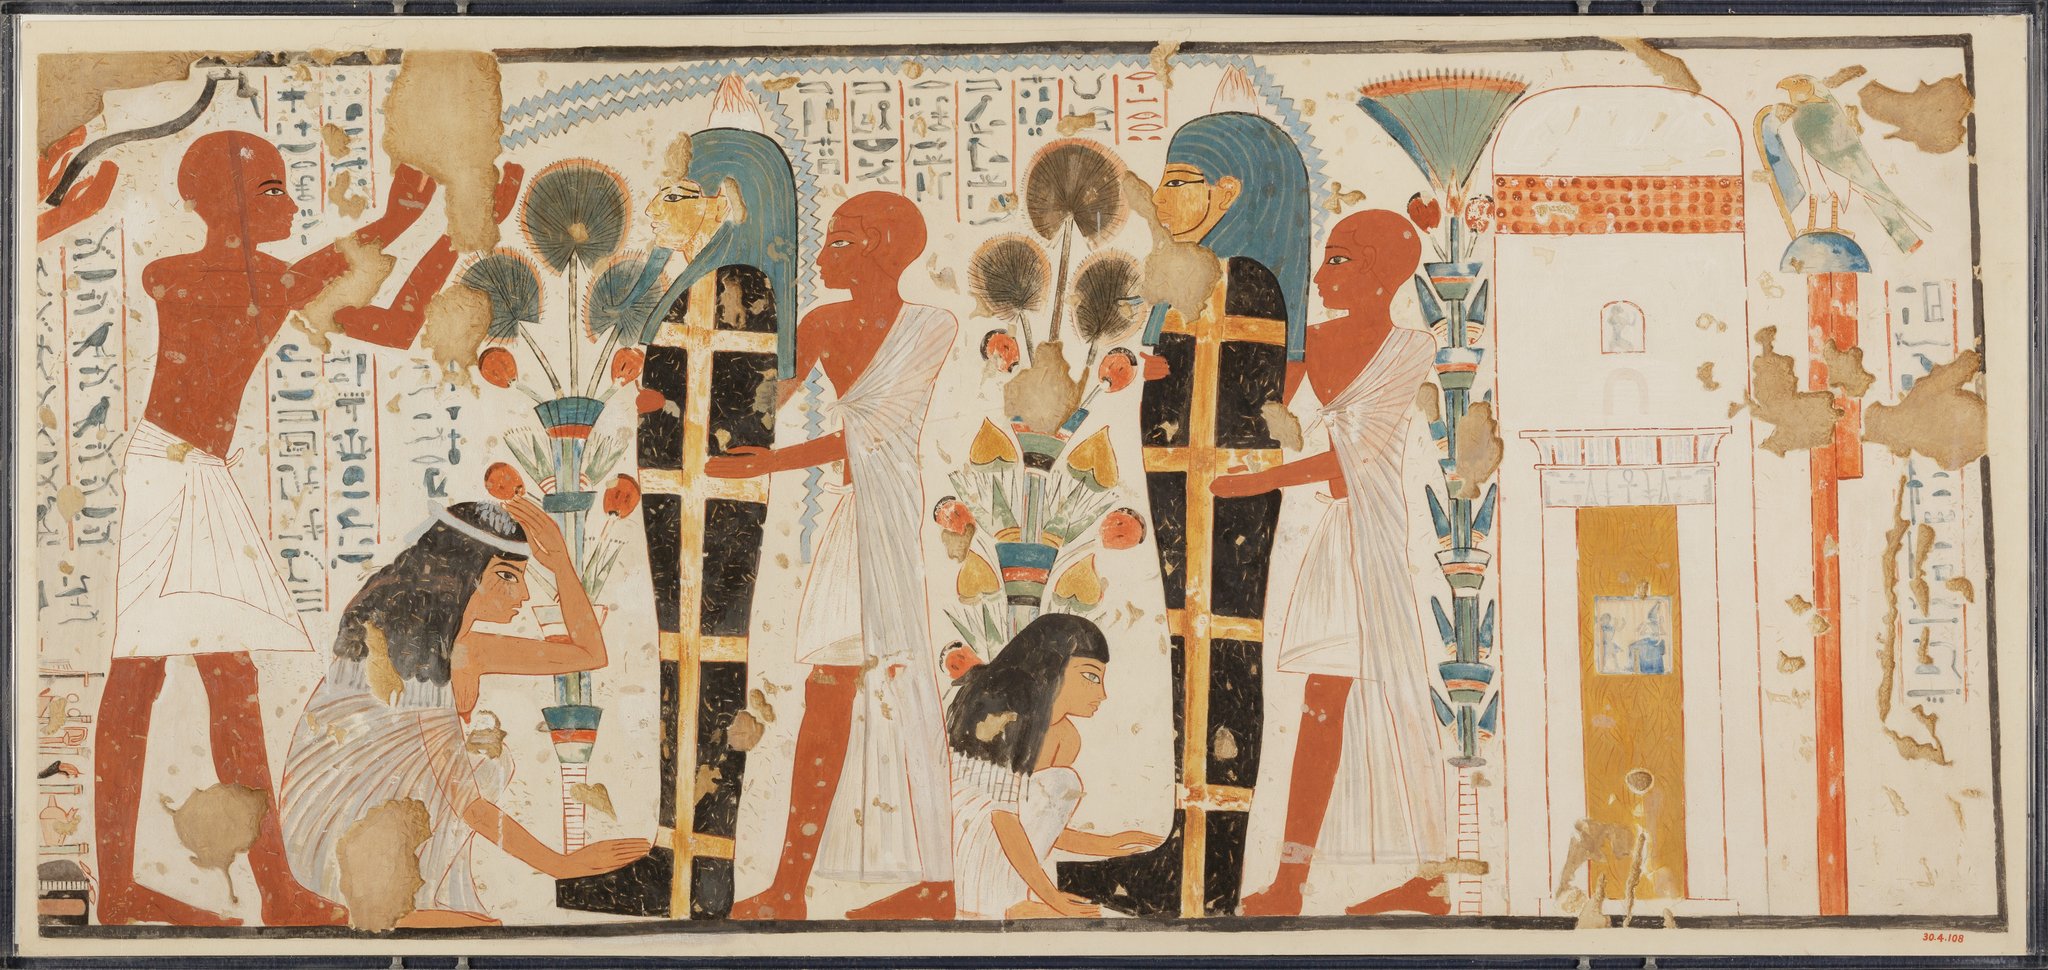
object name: facsimile, nebamun tt 181, ipuky, purifying, mourning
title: Purifying and Mourning the Dead, Tomb of Nebamun and Ipuky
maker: charles k. wilkinson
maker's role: artist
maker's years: 1897-1986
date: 1390-1349 BCE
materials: paper, paint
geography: egypt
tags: men,women,hieroglyphs,funerals,sarcophagus